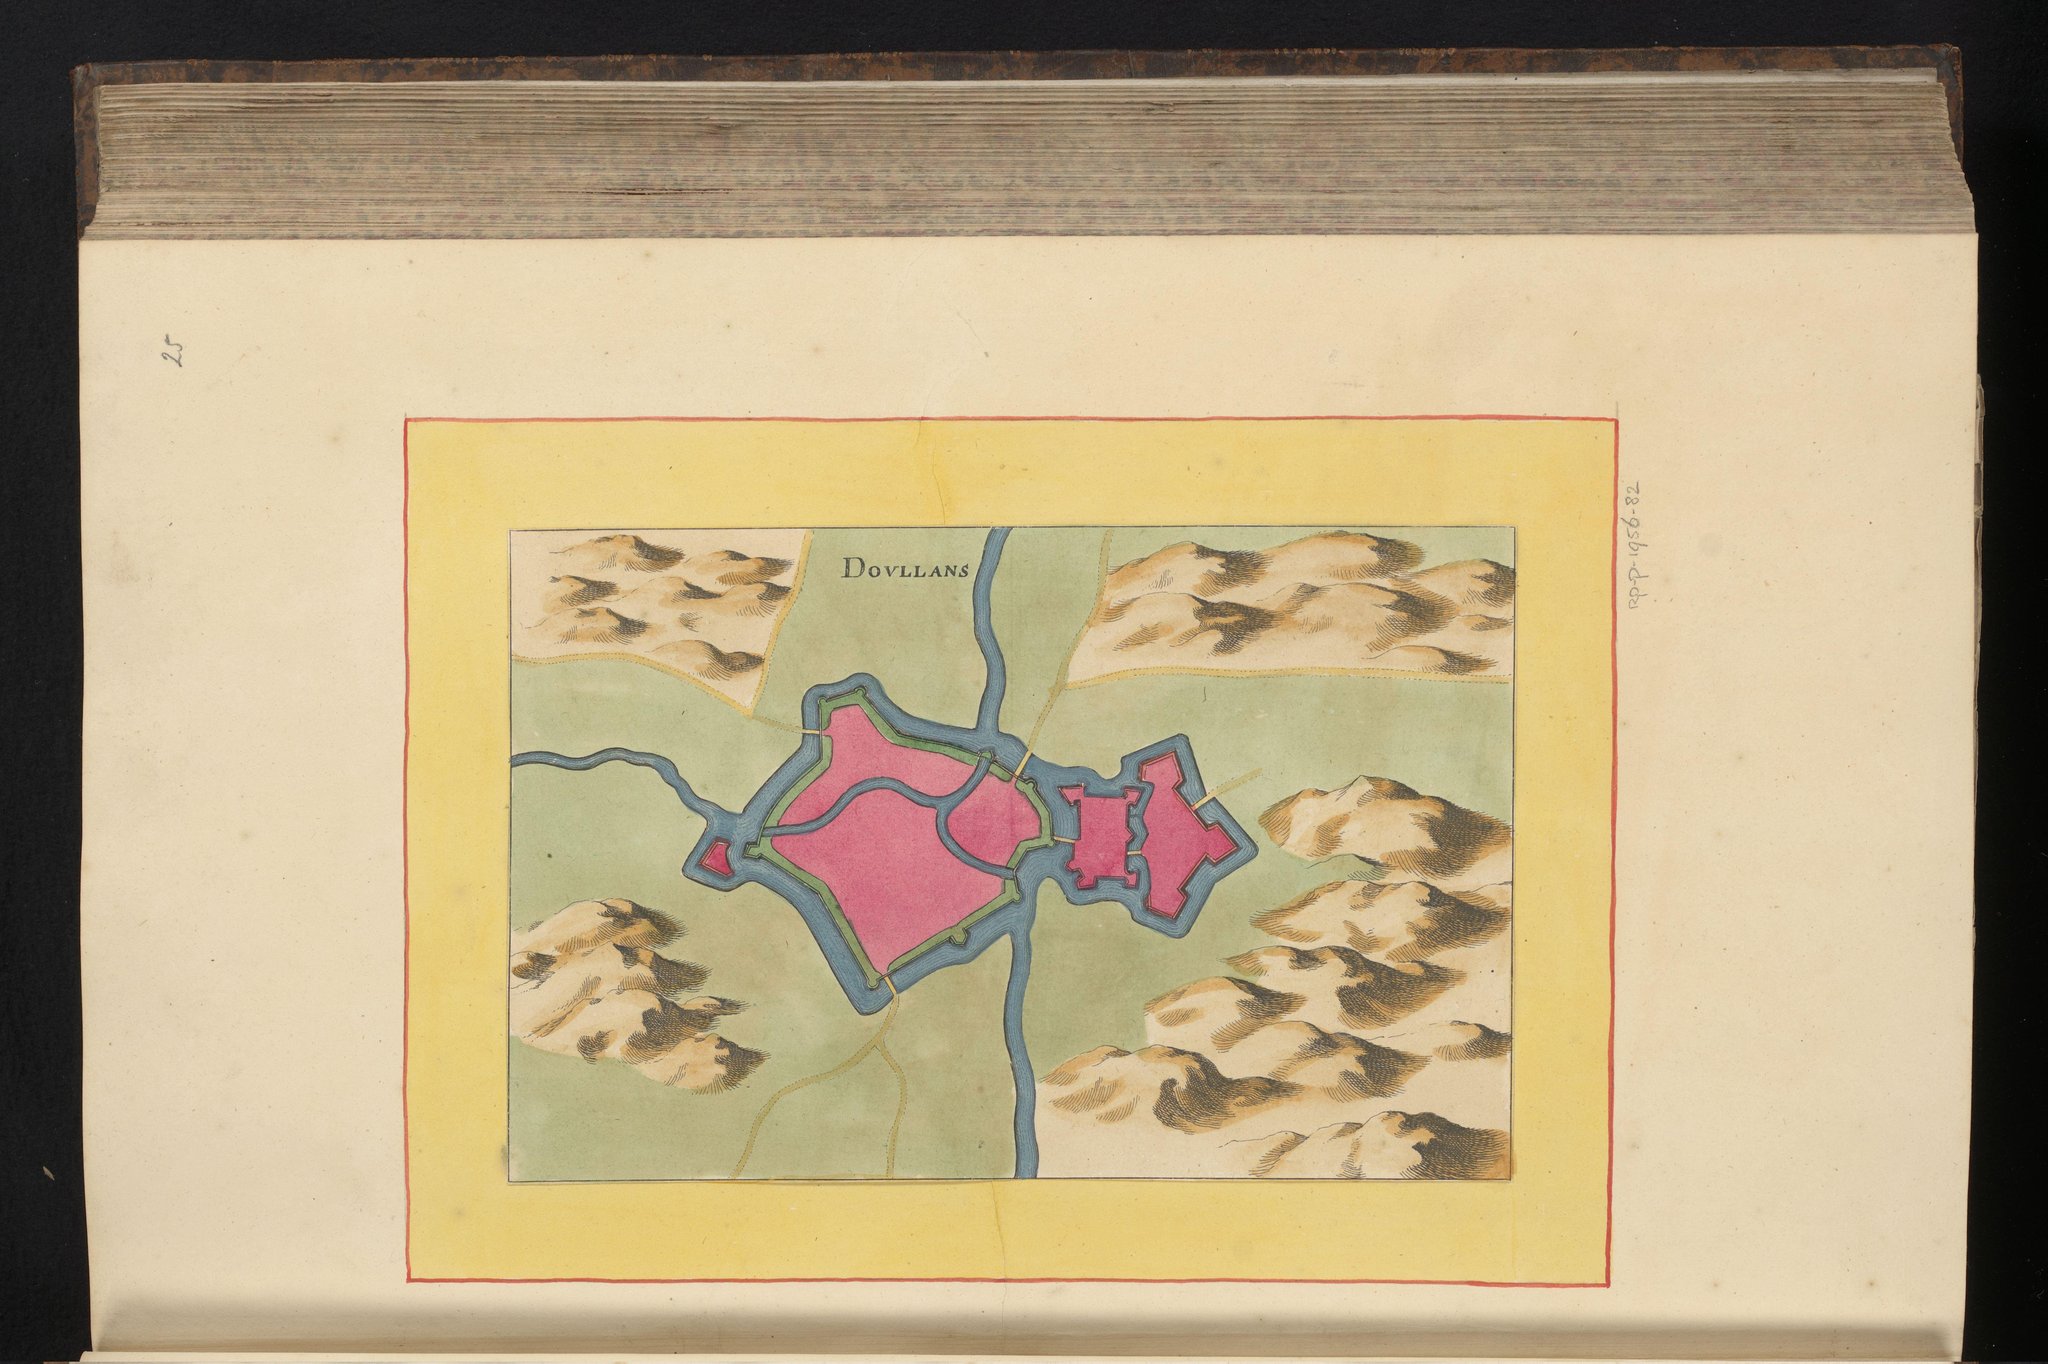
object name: area plan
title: Doullans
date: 1656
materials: paper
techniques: engraving, etching, hand coloring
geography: the hague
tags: maps of cities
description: Prent uit: Zeiller, Martin. Topographia Galliae. 13 dln. Frankfurt: Caspar Merian, 1656, dl. 2, na p. 22.